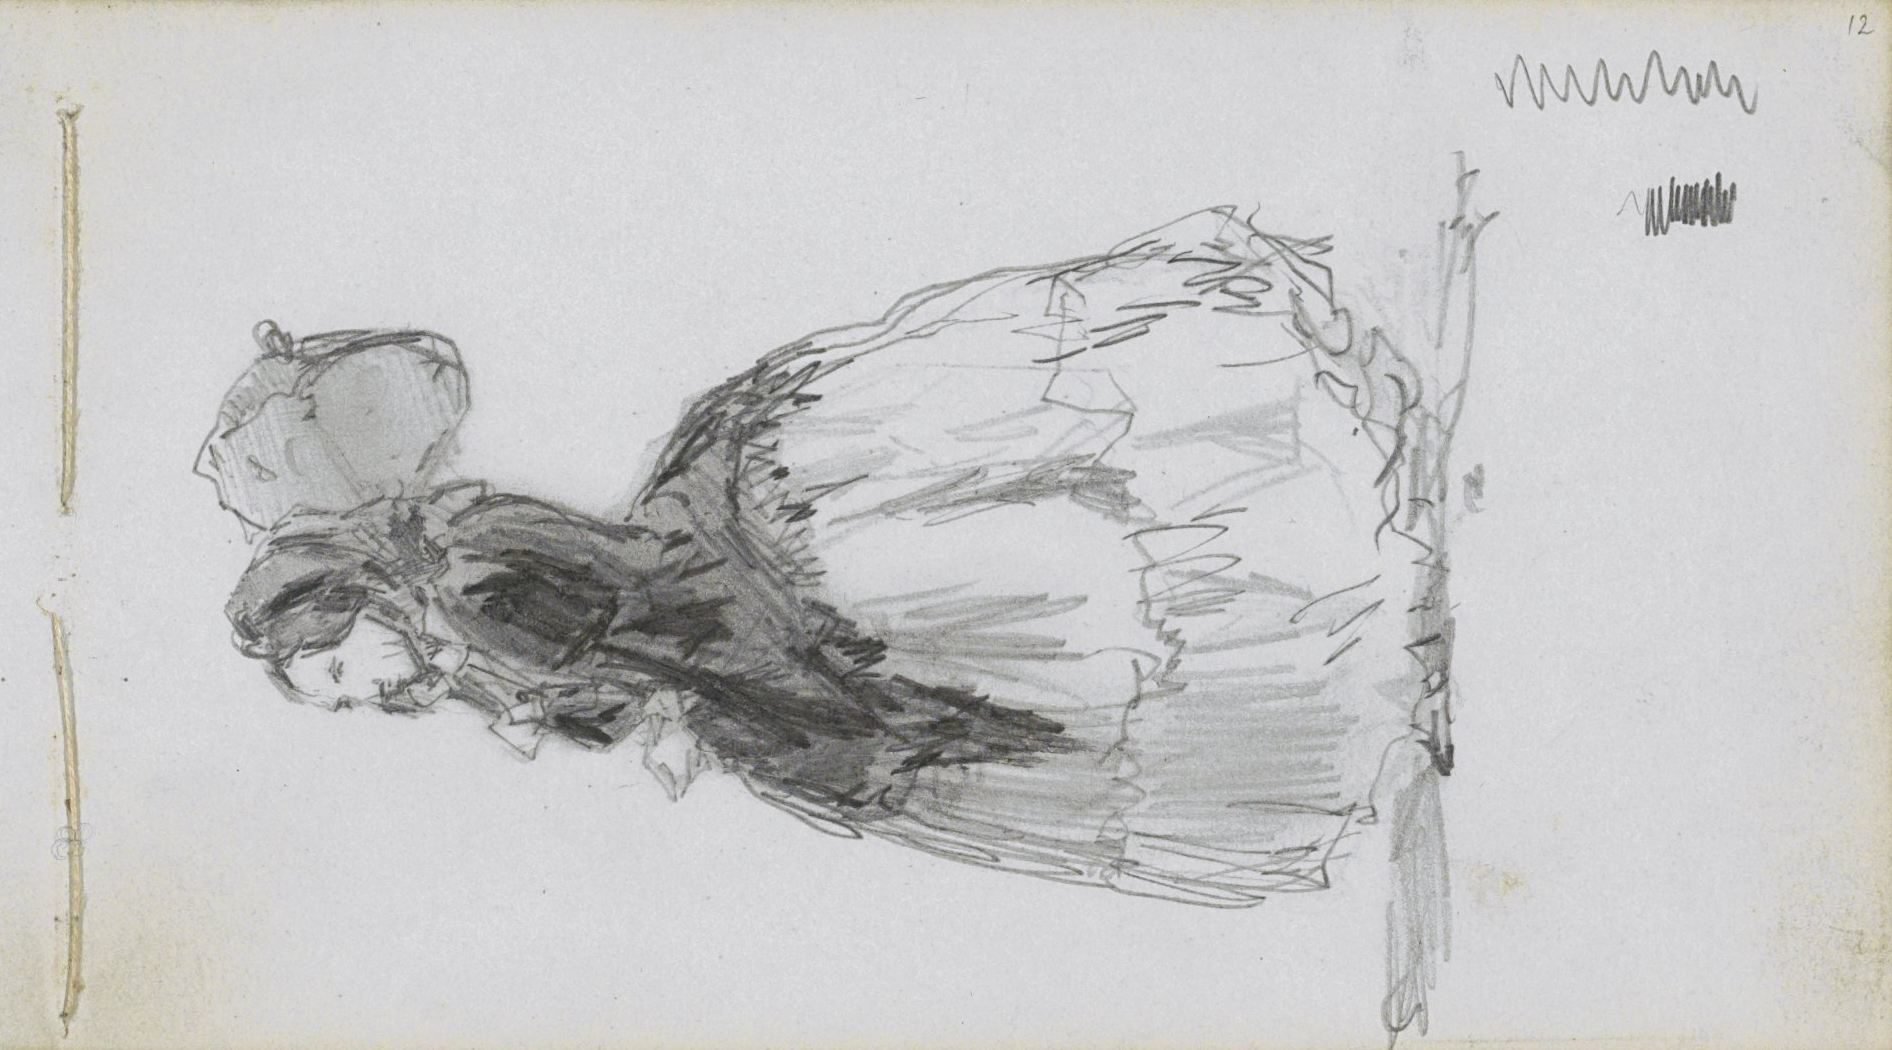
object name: sketchbook leaf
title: Vrouw met een parasol in een lange jurk en mantel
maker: johan hendrik weissenbruch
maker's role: draughtsman, painter, print maker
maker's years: 1824-1903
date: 1834-1903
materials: paper, pencil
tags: dress, gown (+ women's clothes), parasol, sunshade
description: Blad 12 recto uit een schetsboek met 39 bladen.